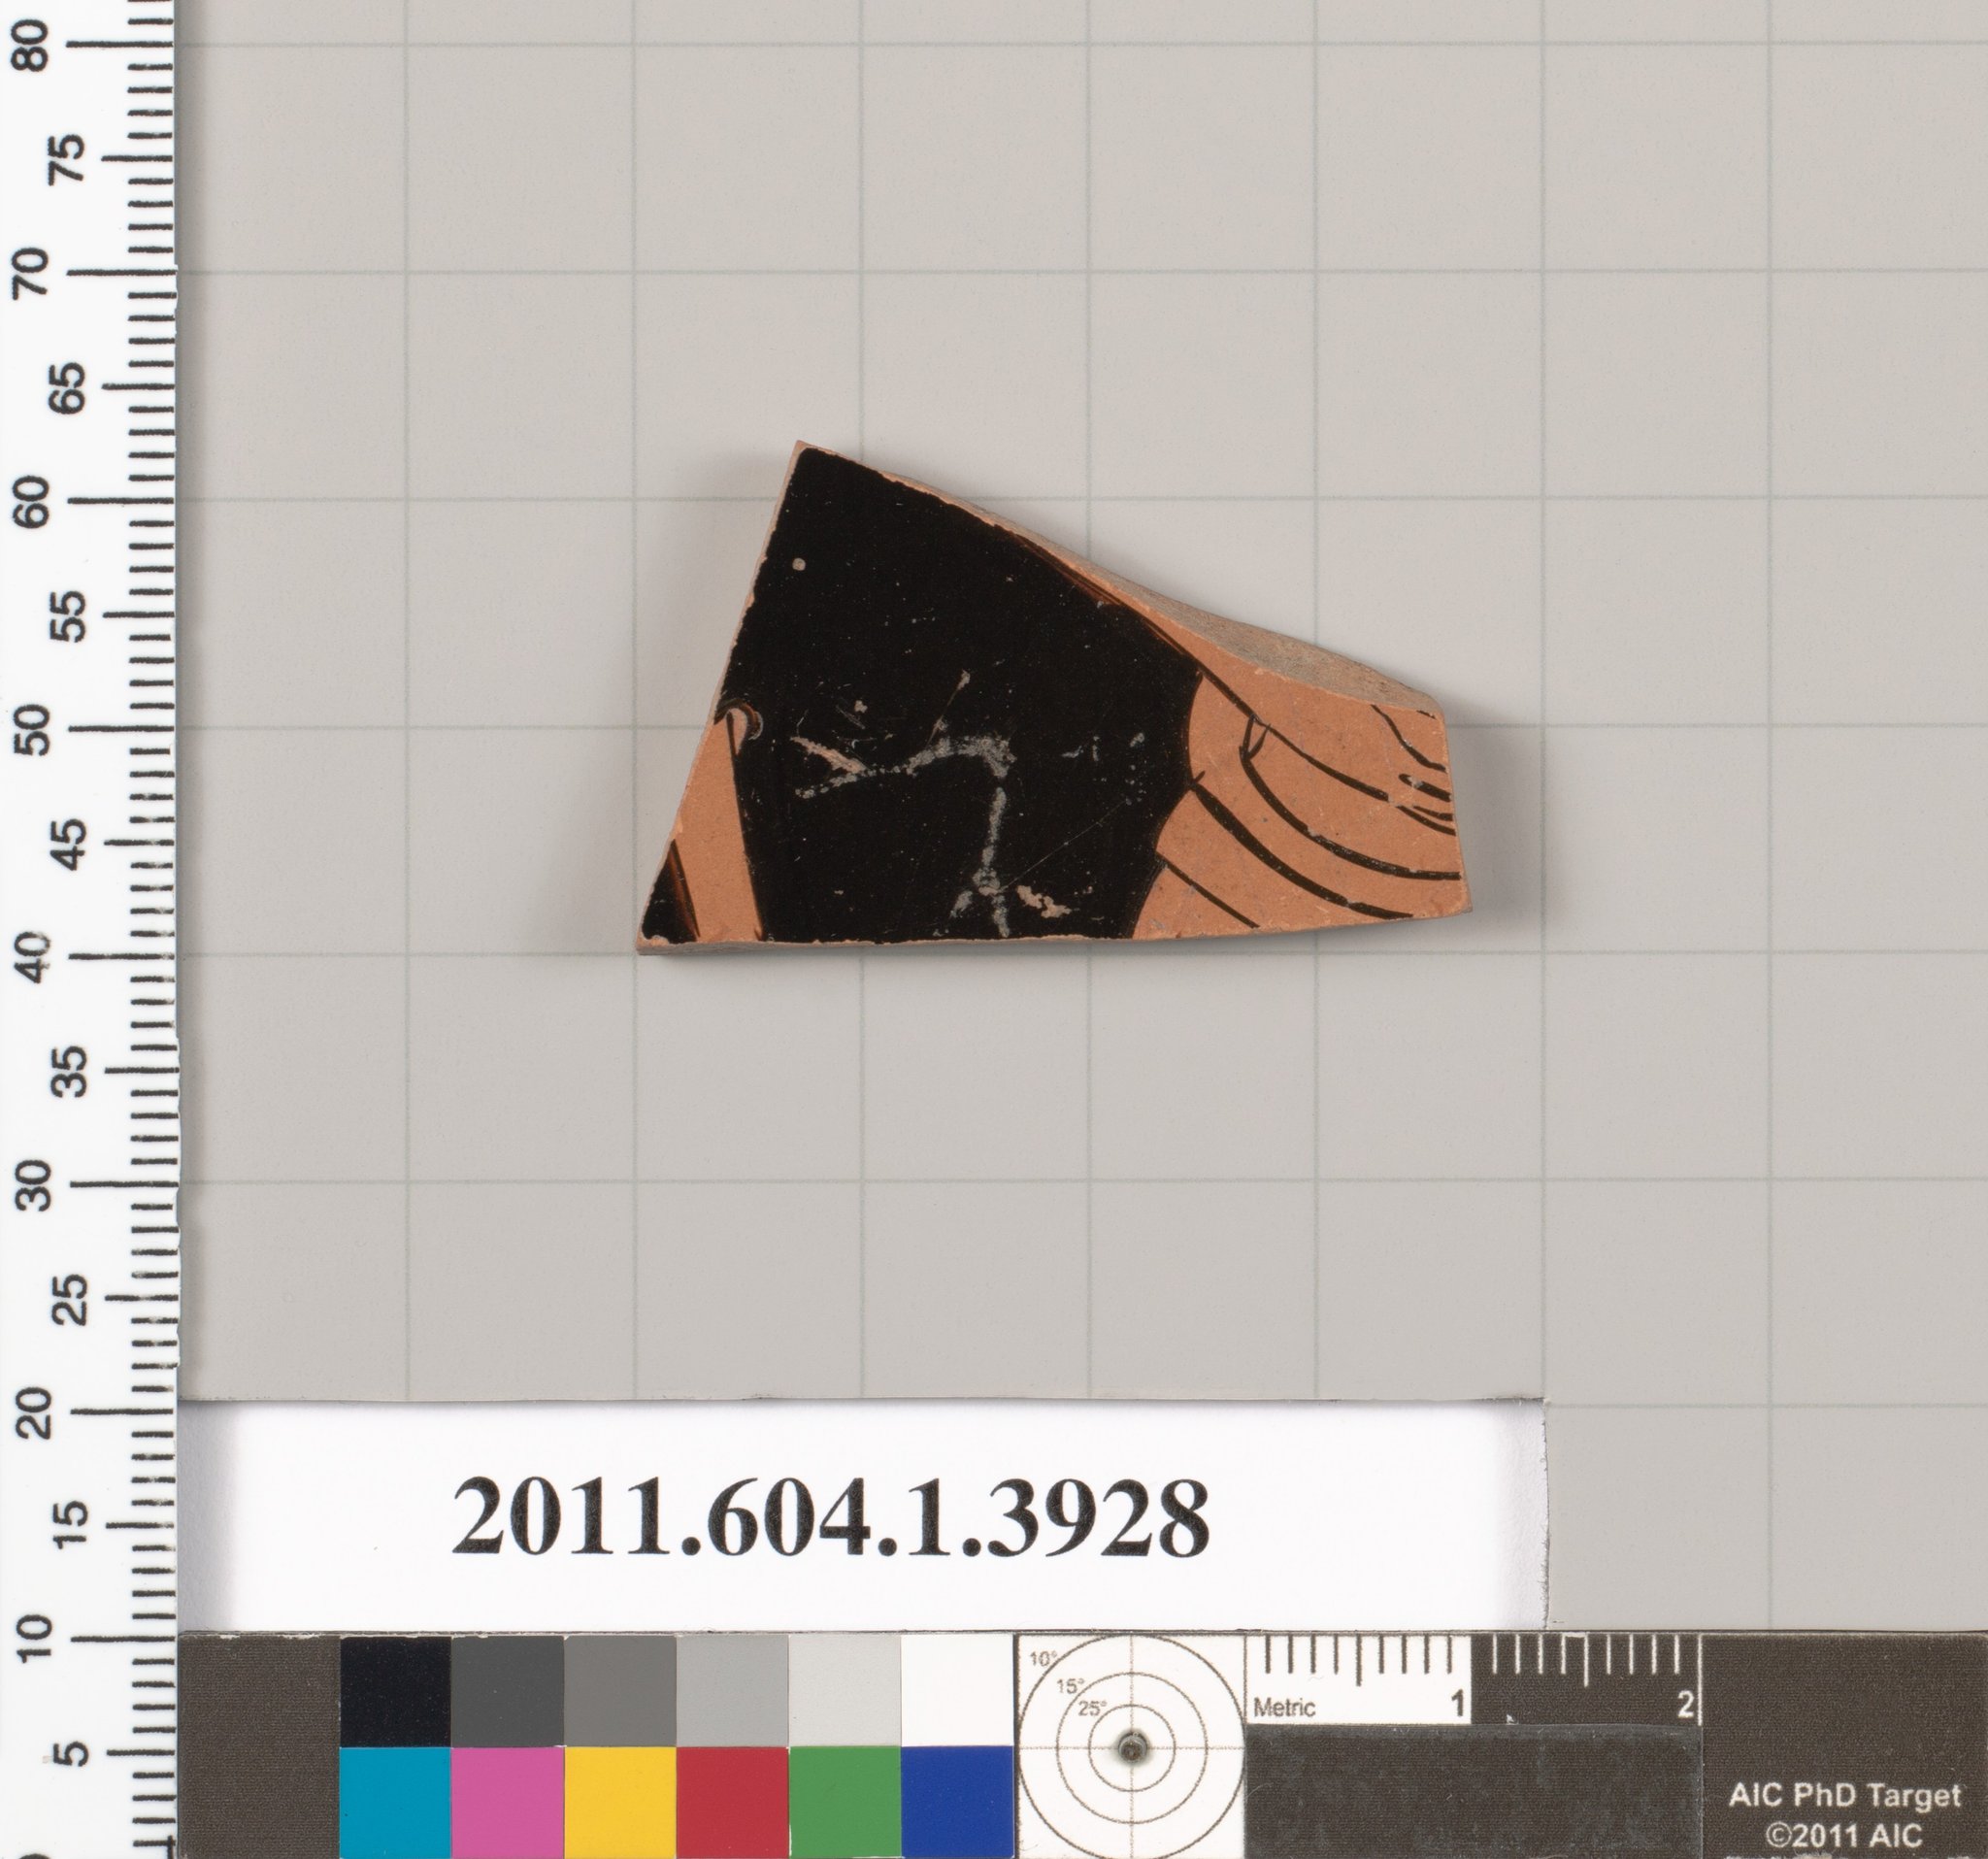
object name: kylix fragment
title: Terracotta fragment of a kylix (drinking cup)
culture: greek, attic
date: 510-490 BCE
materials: terracotta